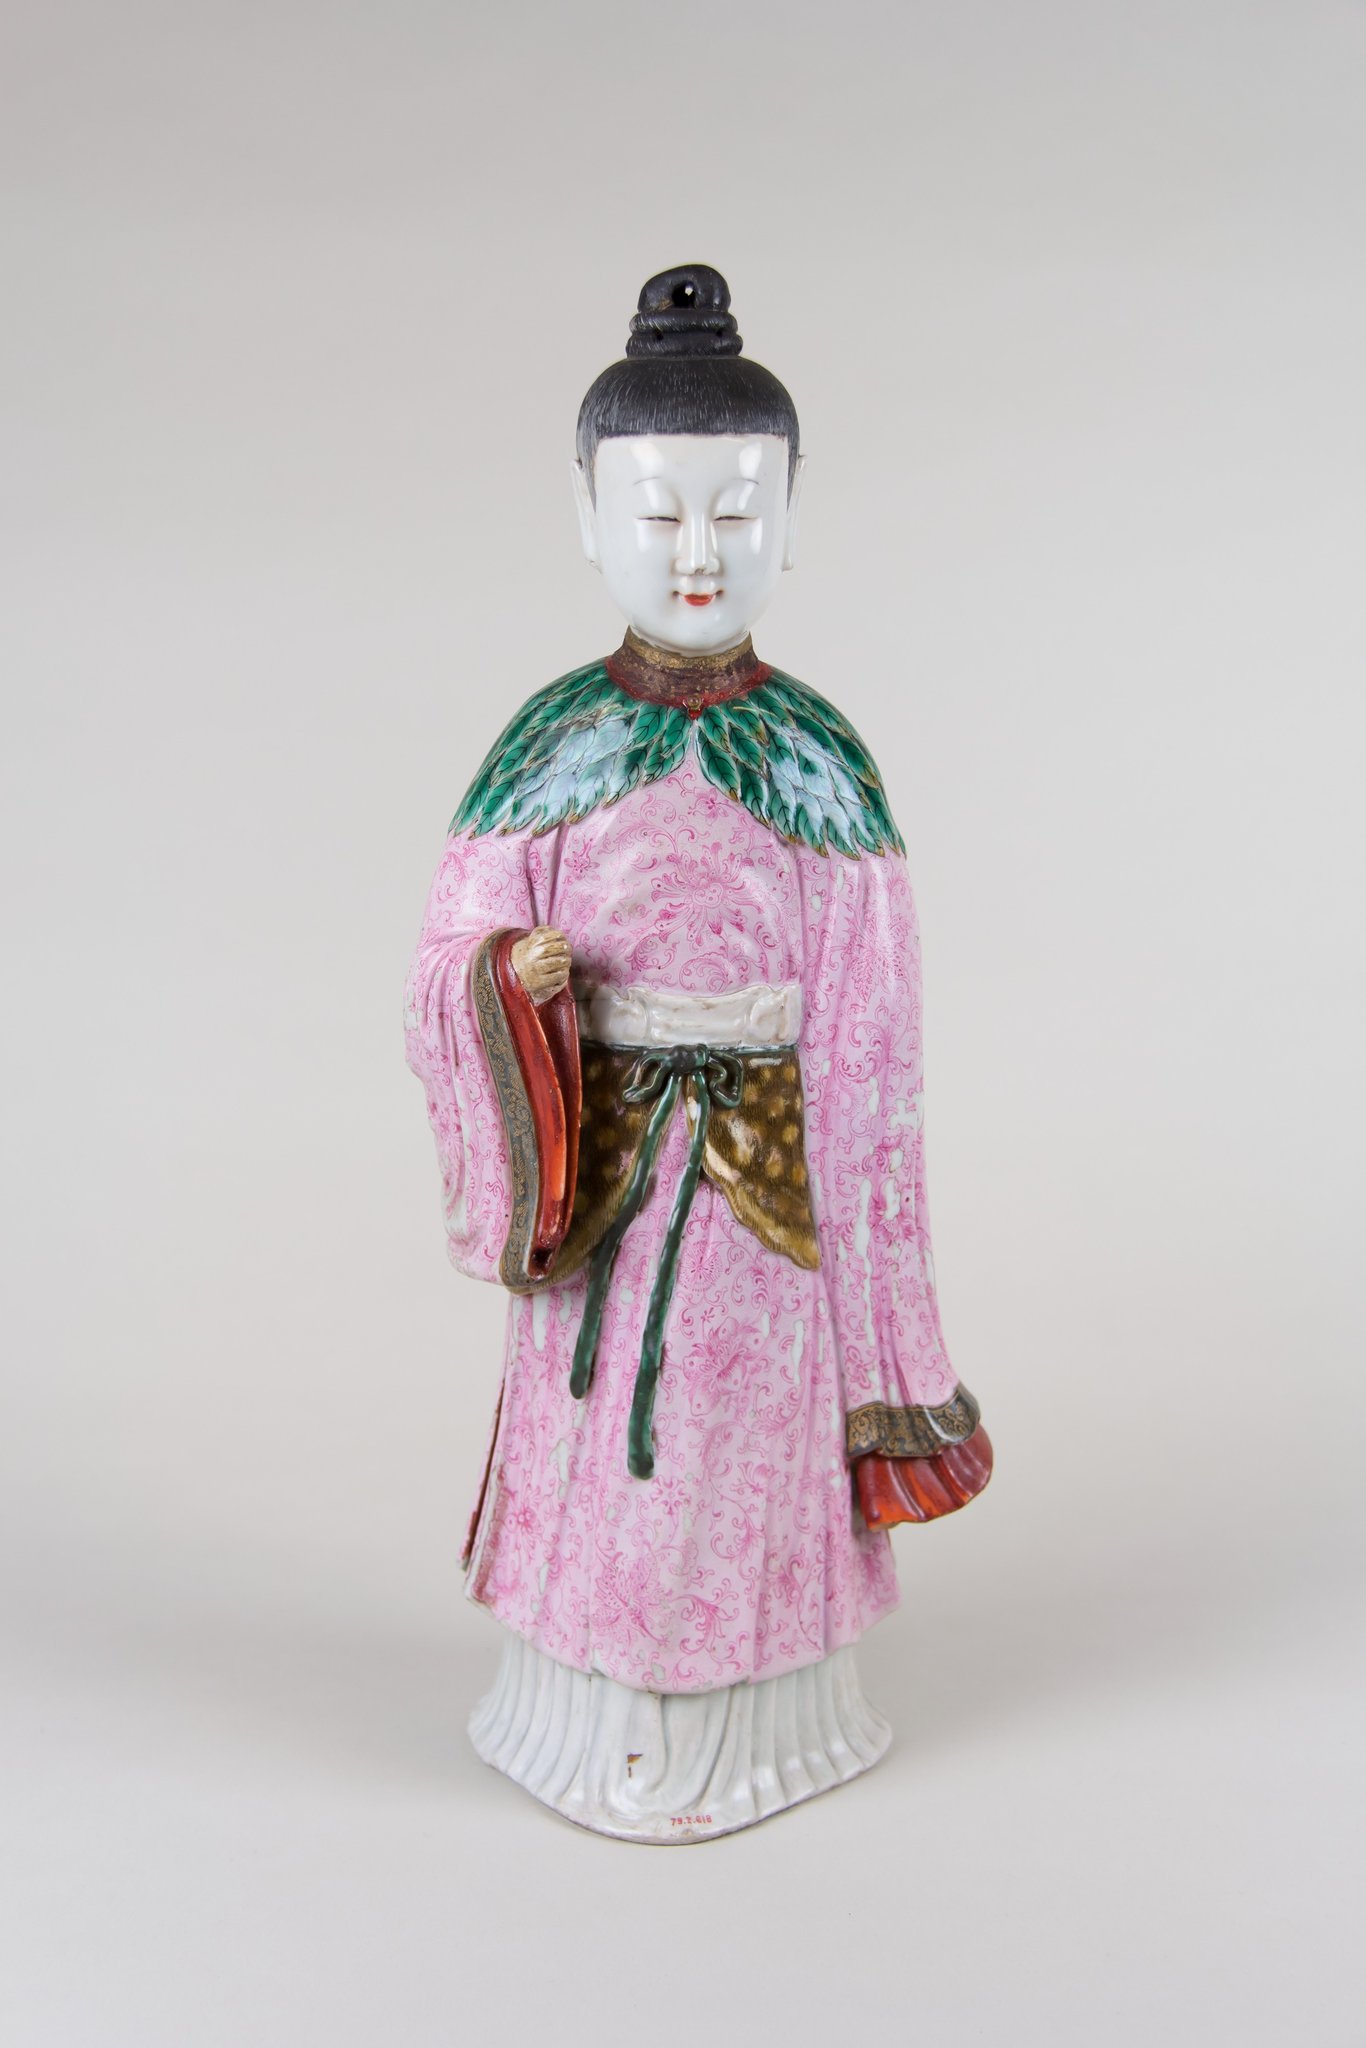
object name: figure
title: Figure of fairy Magu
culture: chinese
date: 1751-1800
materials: enamel, porcelain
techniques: overglaze, painting, polychrome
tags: women